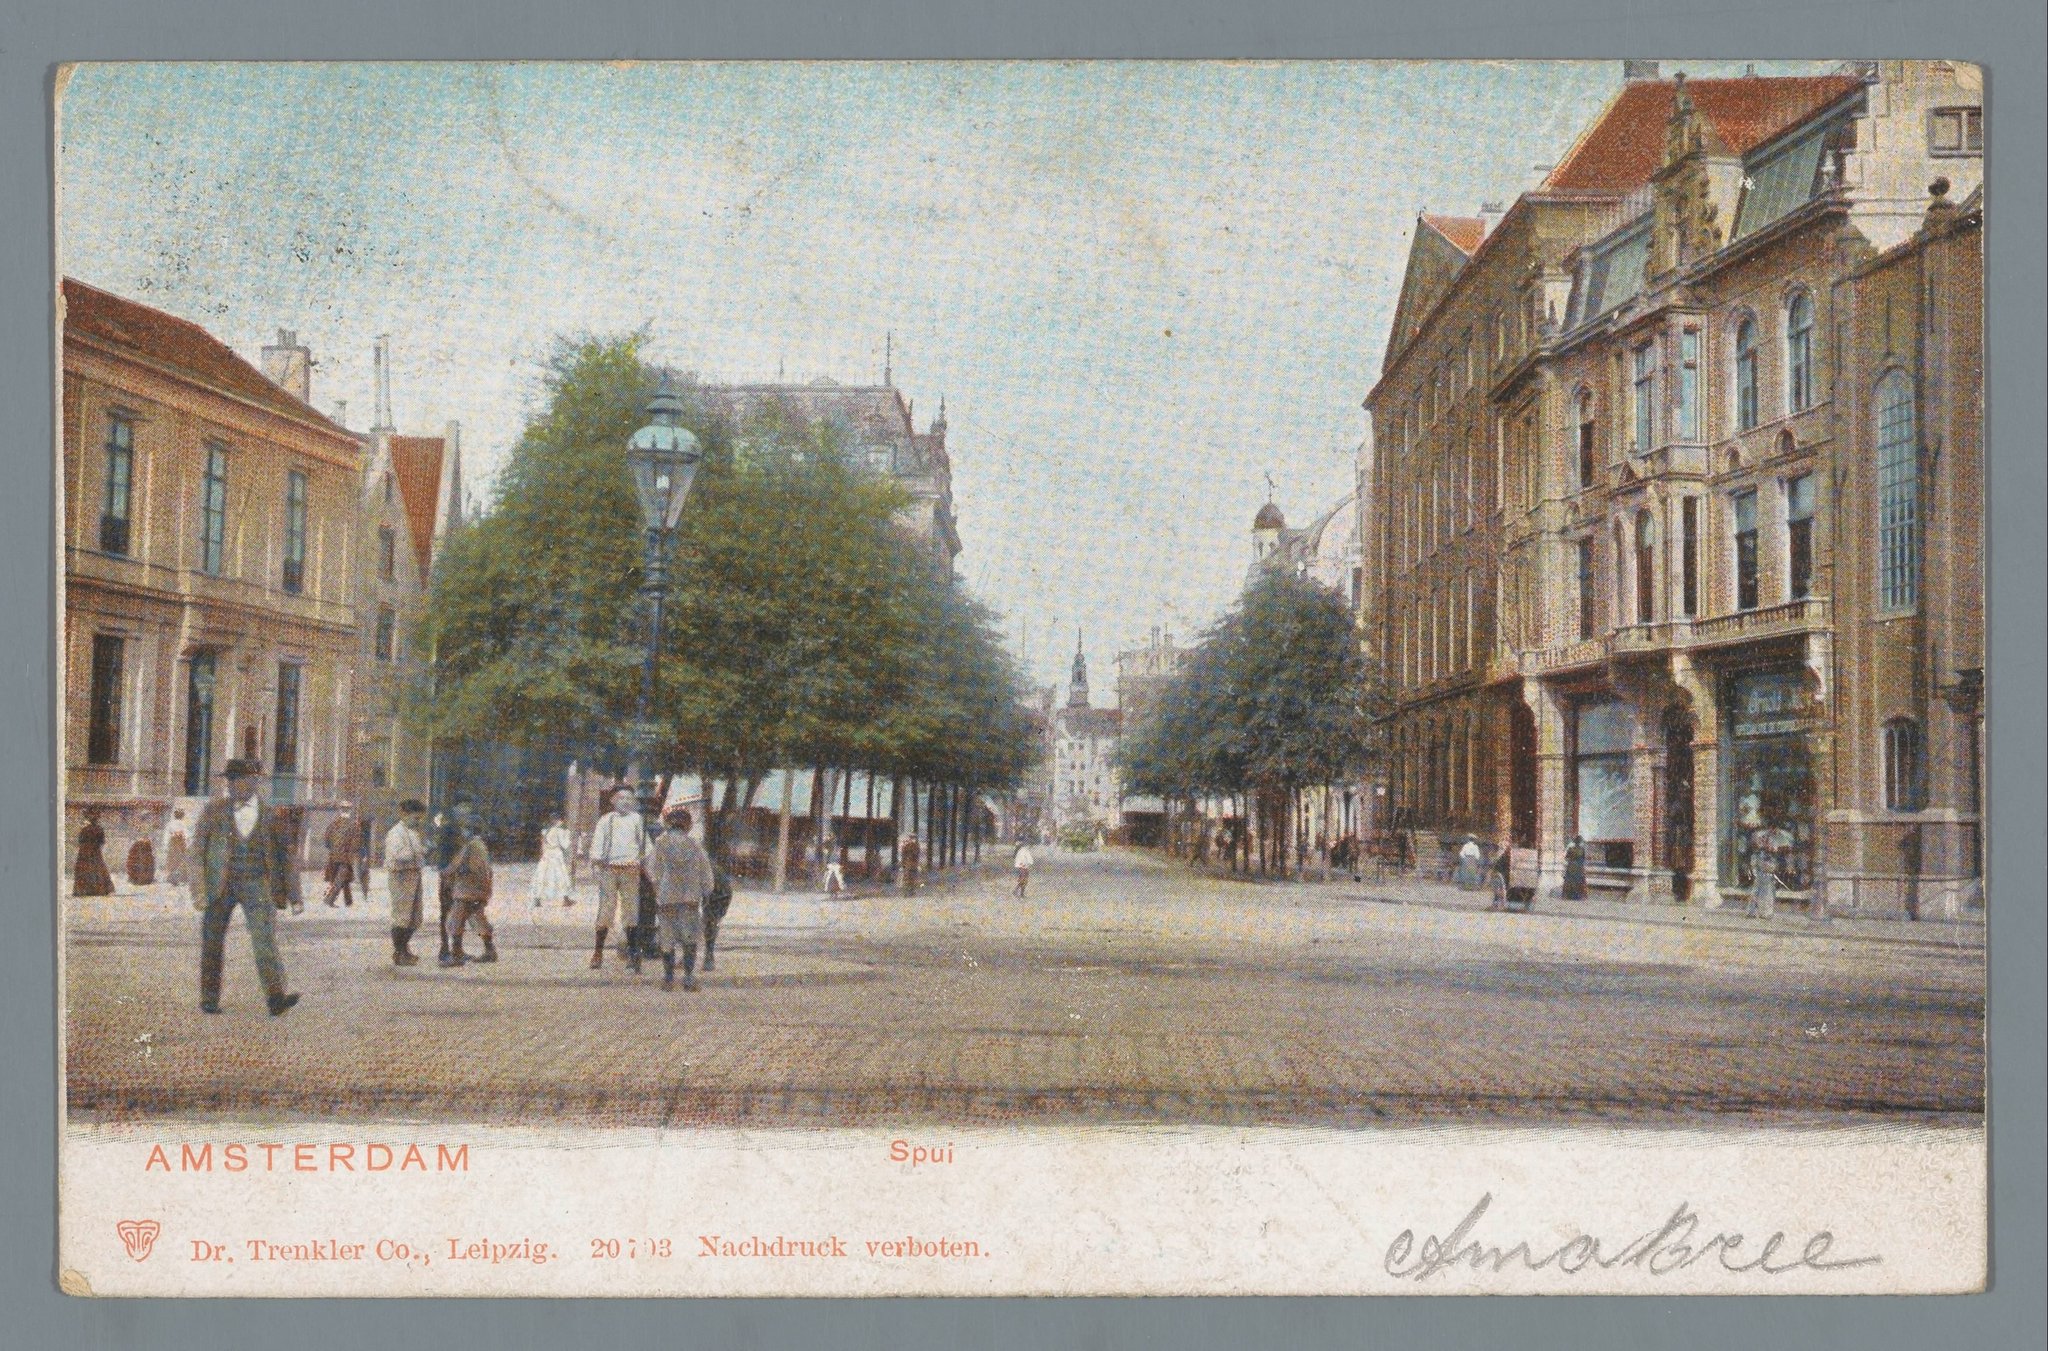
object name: ansichtkaart, prentbriefkaart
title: Amsterdam, Spui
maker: Anonymous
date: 1904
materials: cardboard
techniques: writing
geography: leipzig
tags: square, place, circus, etc.